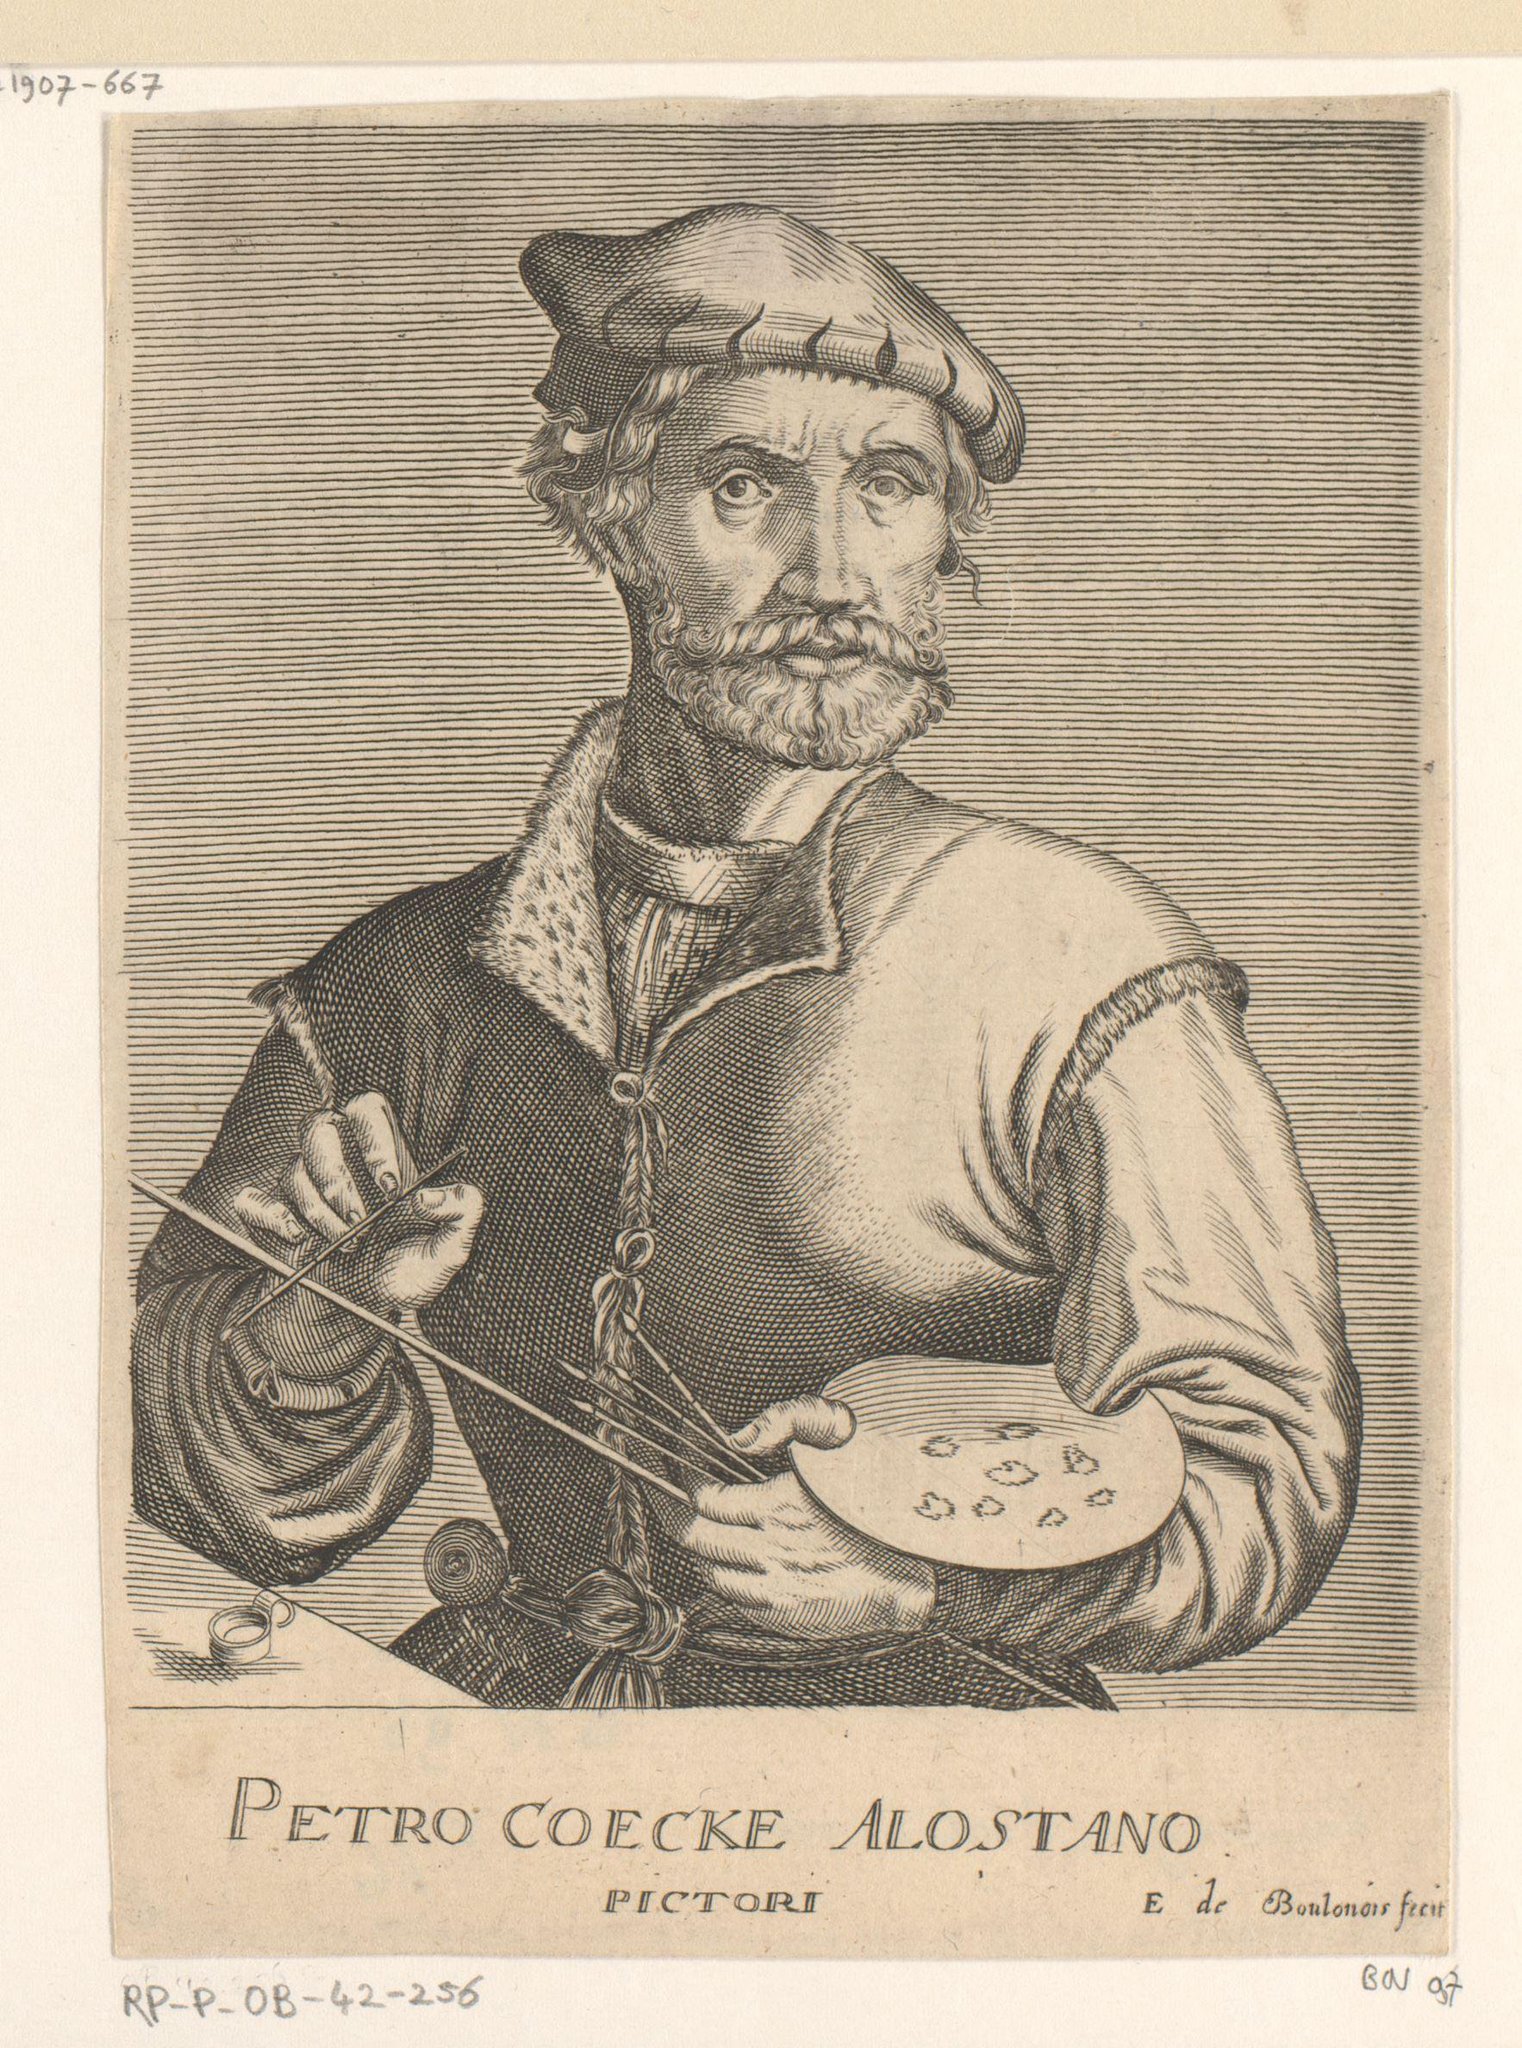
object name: print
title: Portret van Pieter Coecke van Aelst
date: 1682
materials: paper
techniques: engraving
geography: brussels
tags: brussels, print maker, draughtsman, pieter coecke van aelst (i), historical persons, portrait, self-portrait of artist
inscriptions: collector's mark: Lugt 2228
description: Prent uit: Bullert, Isaac. Académie des Sciences et Arts contenant les vies et éloges his. des hommes illustres qui ont excellé en ces professions depuis environ quatre siècles. Brussel: Foppens, François, 1682. Het boek werd in 1682 eveneens in Amsterdam uitgegeven door de erfgenamen van Daniel Elzevier. Deze portretten dienen ter illustratie van de biografie van een kunstenaar of geleerde. De meeste portretten werden door Nicolas de Larmessin vervaardigd (162), 93 door De Boulonois en een derde door ongeïdentificeerde prentmakers. Dit betreft een illustratie op p. 405, deel II.